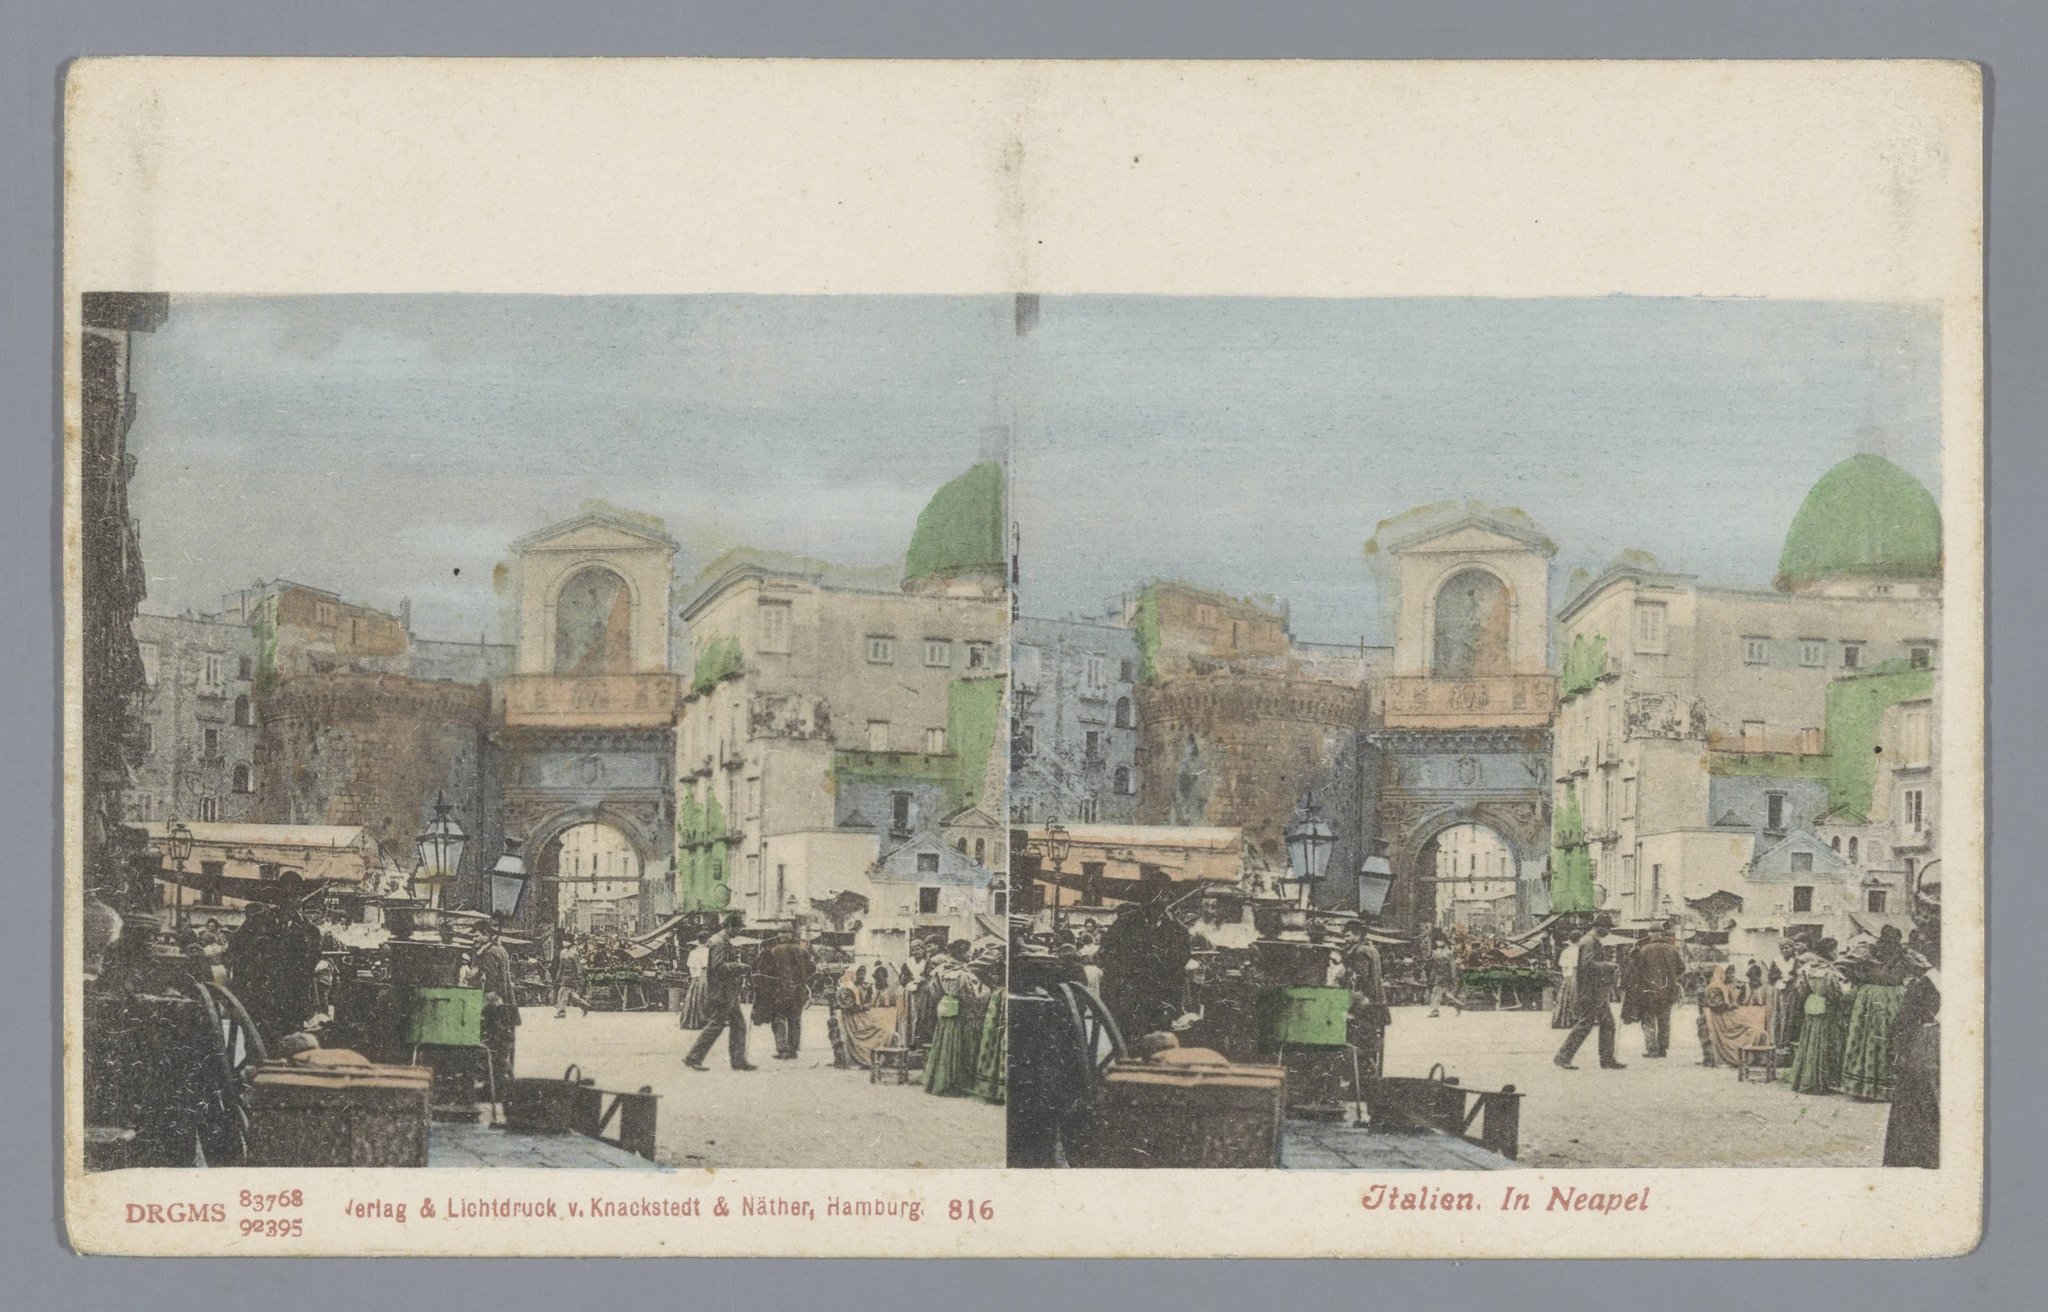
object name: stereograph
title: Markt in Napels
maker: Anonymous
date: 1889-1905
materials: cardboard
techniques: photograph, hand coloring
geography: hamburg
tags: market, naples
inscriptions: number: ‘816’, inscription: ‘DRGMS 83768/ 92395’, inscription: ‘Post-Karte’